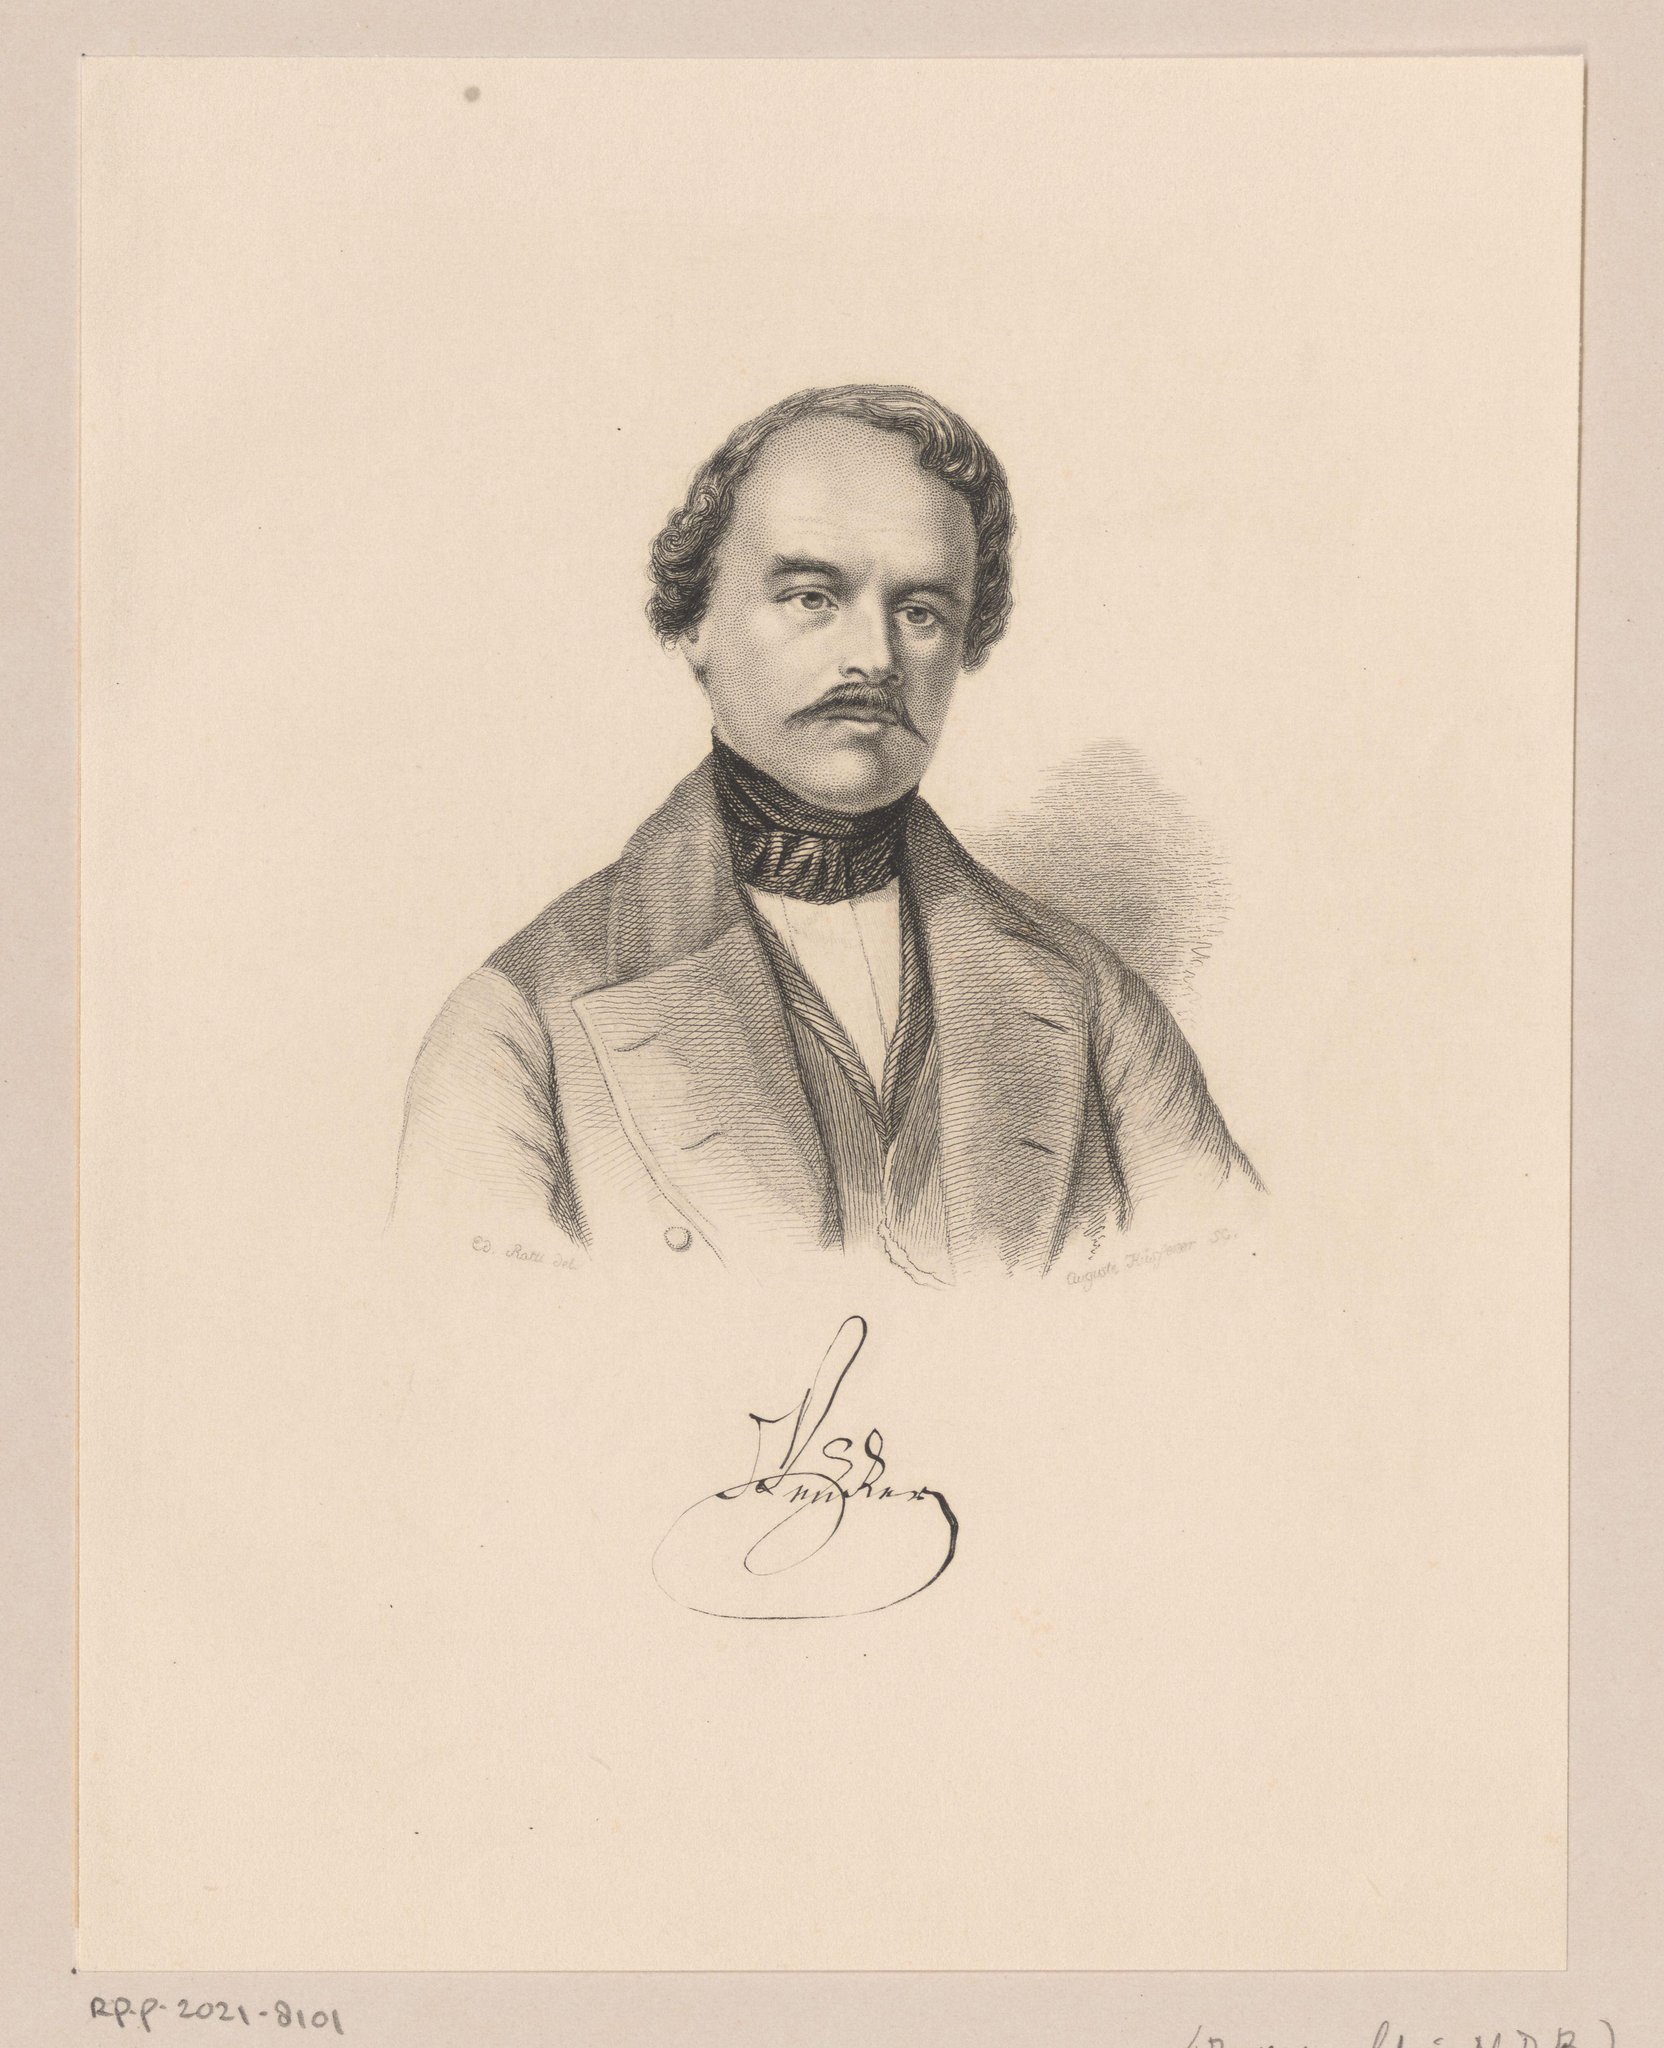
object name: print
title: Portret van Edward von Peucker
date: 1826-1877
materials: paper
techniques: engraving, roulette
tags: berlin, moustache, adult man, historical persons